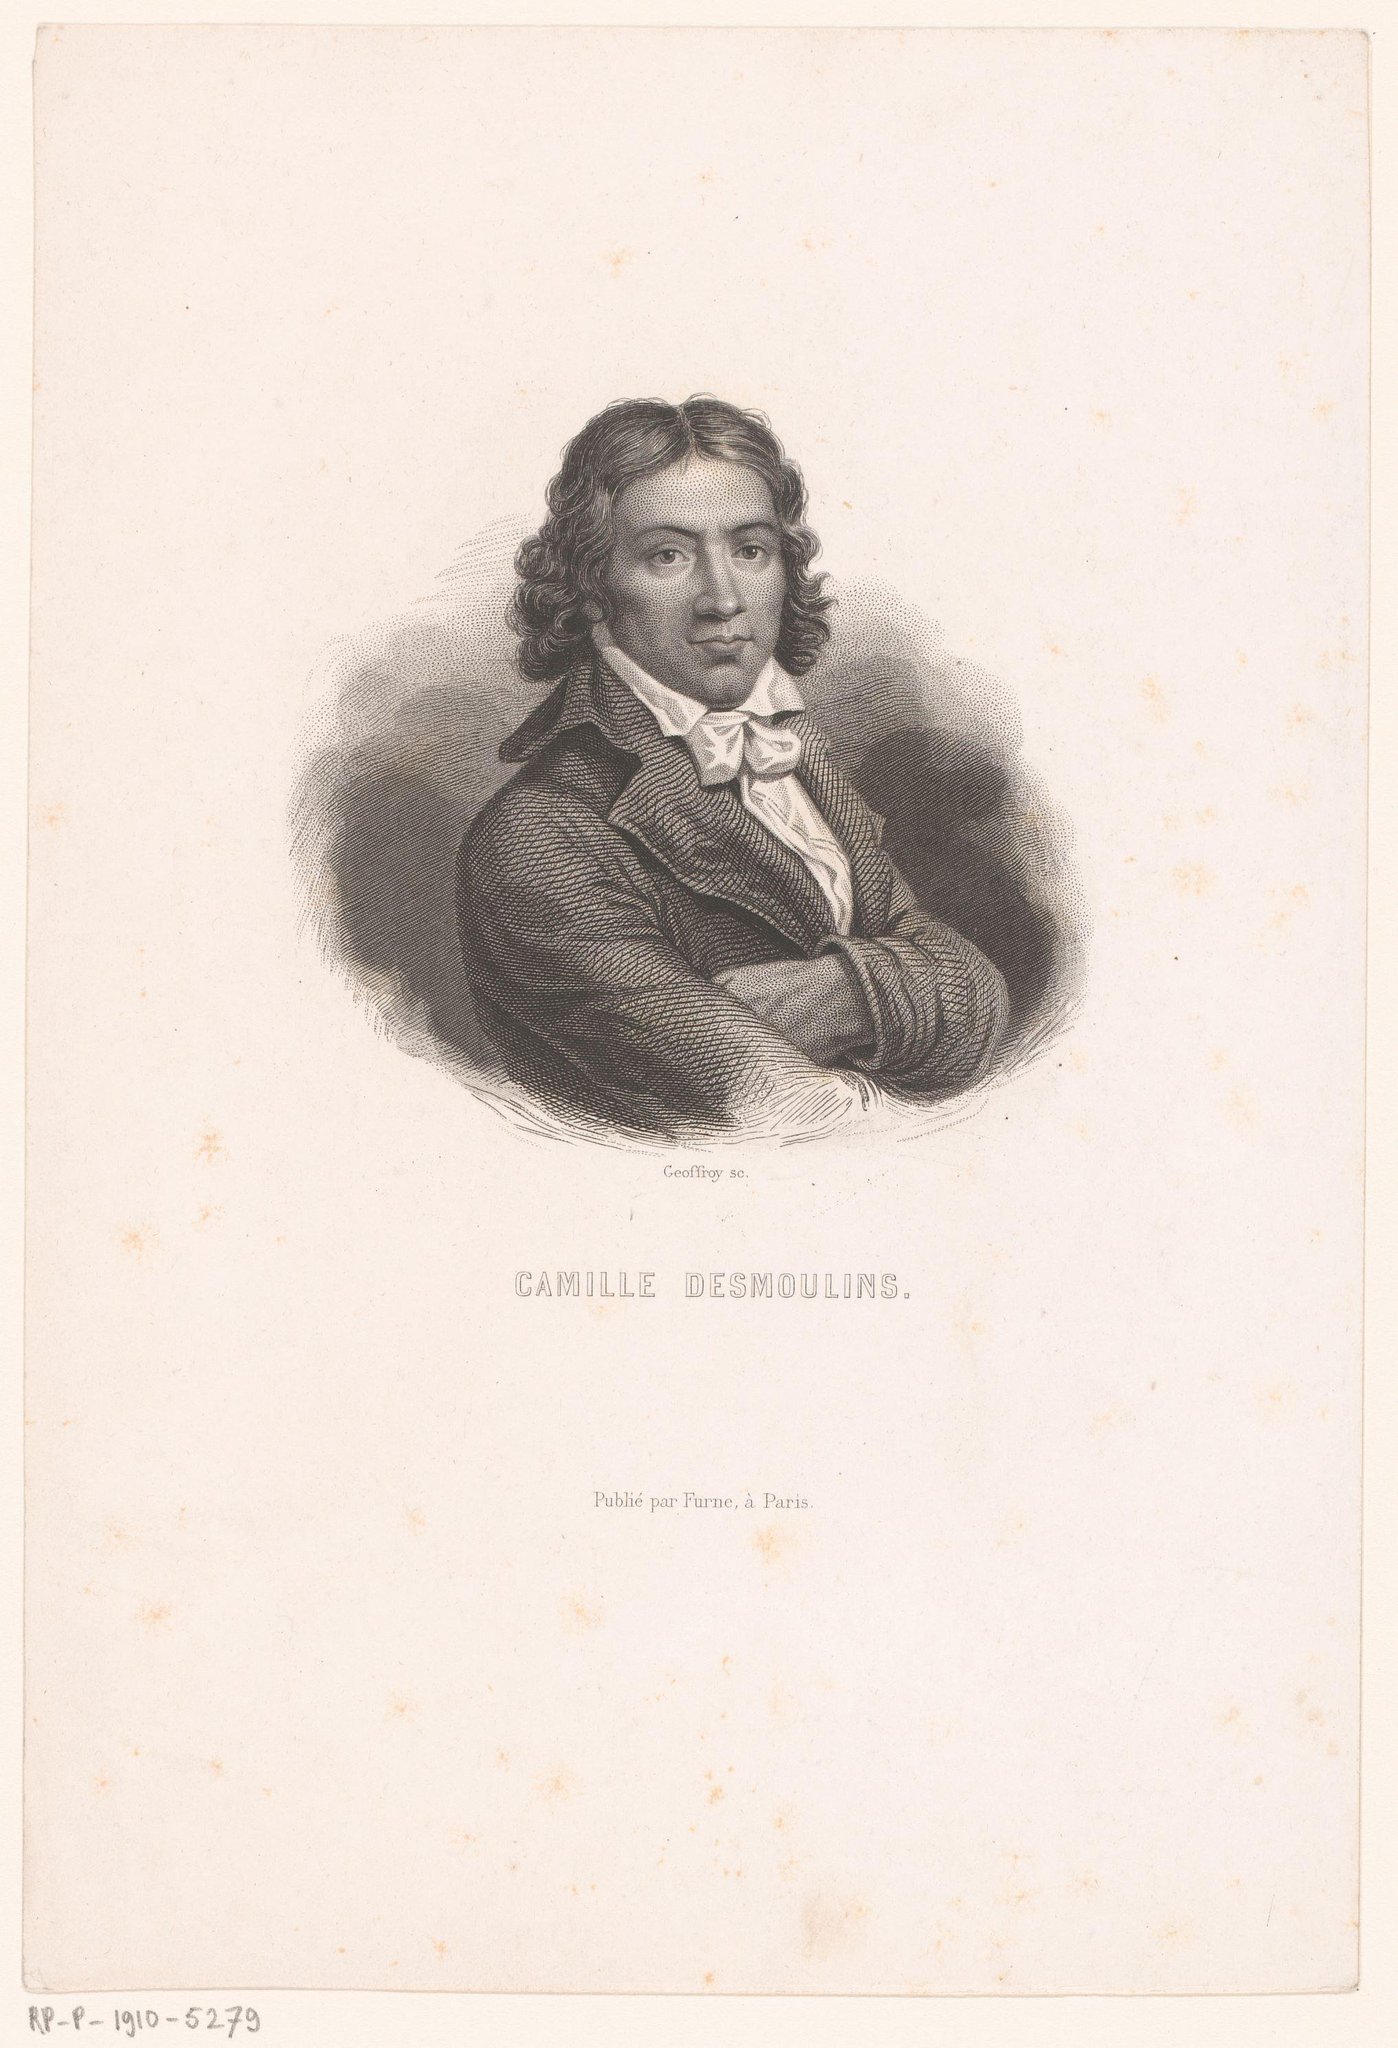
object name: print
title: Portret van Camille Desmoulins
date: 1829-1859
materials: paper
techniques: engraving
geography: paris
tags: paris, politician, historical persons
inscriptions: collector's mark: Lugt 2228